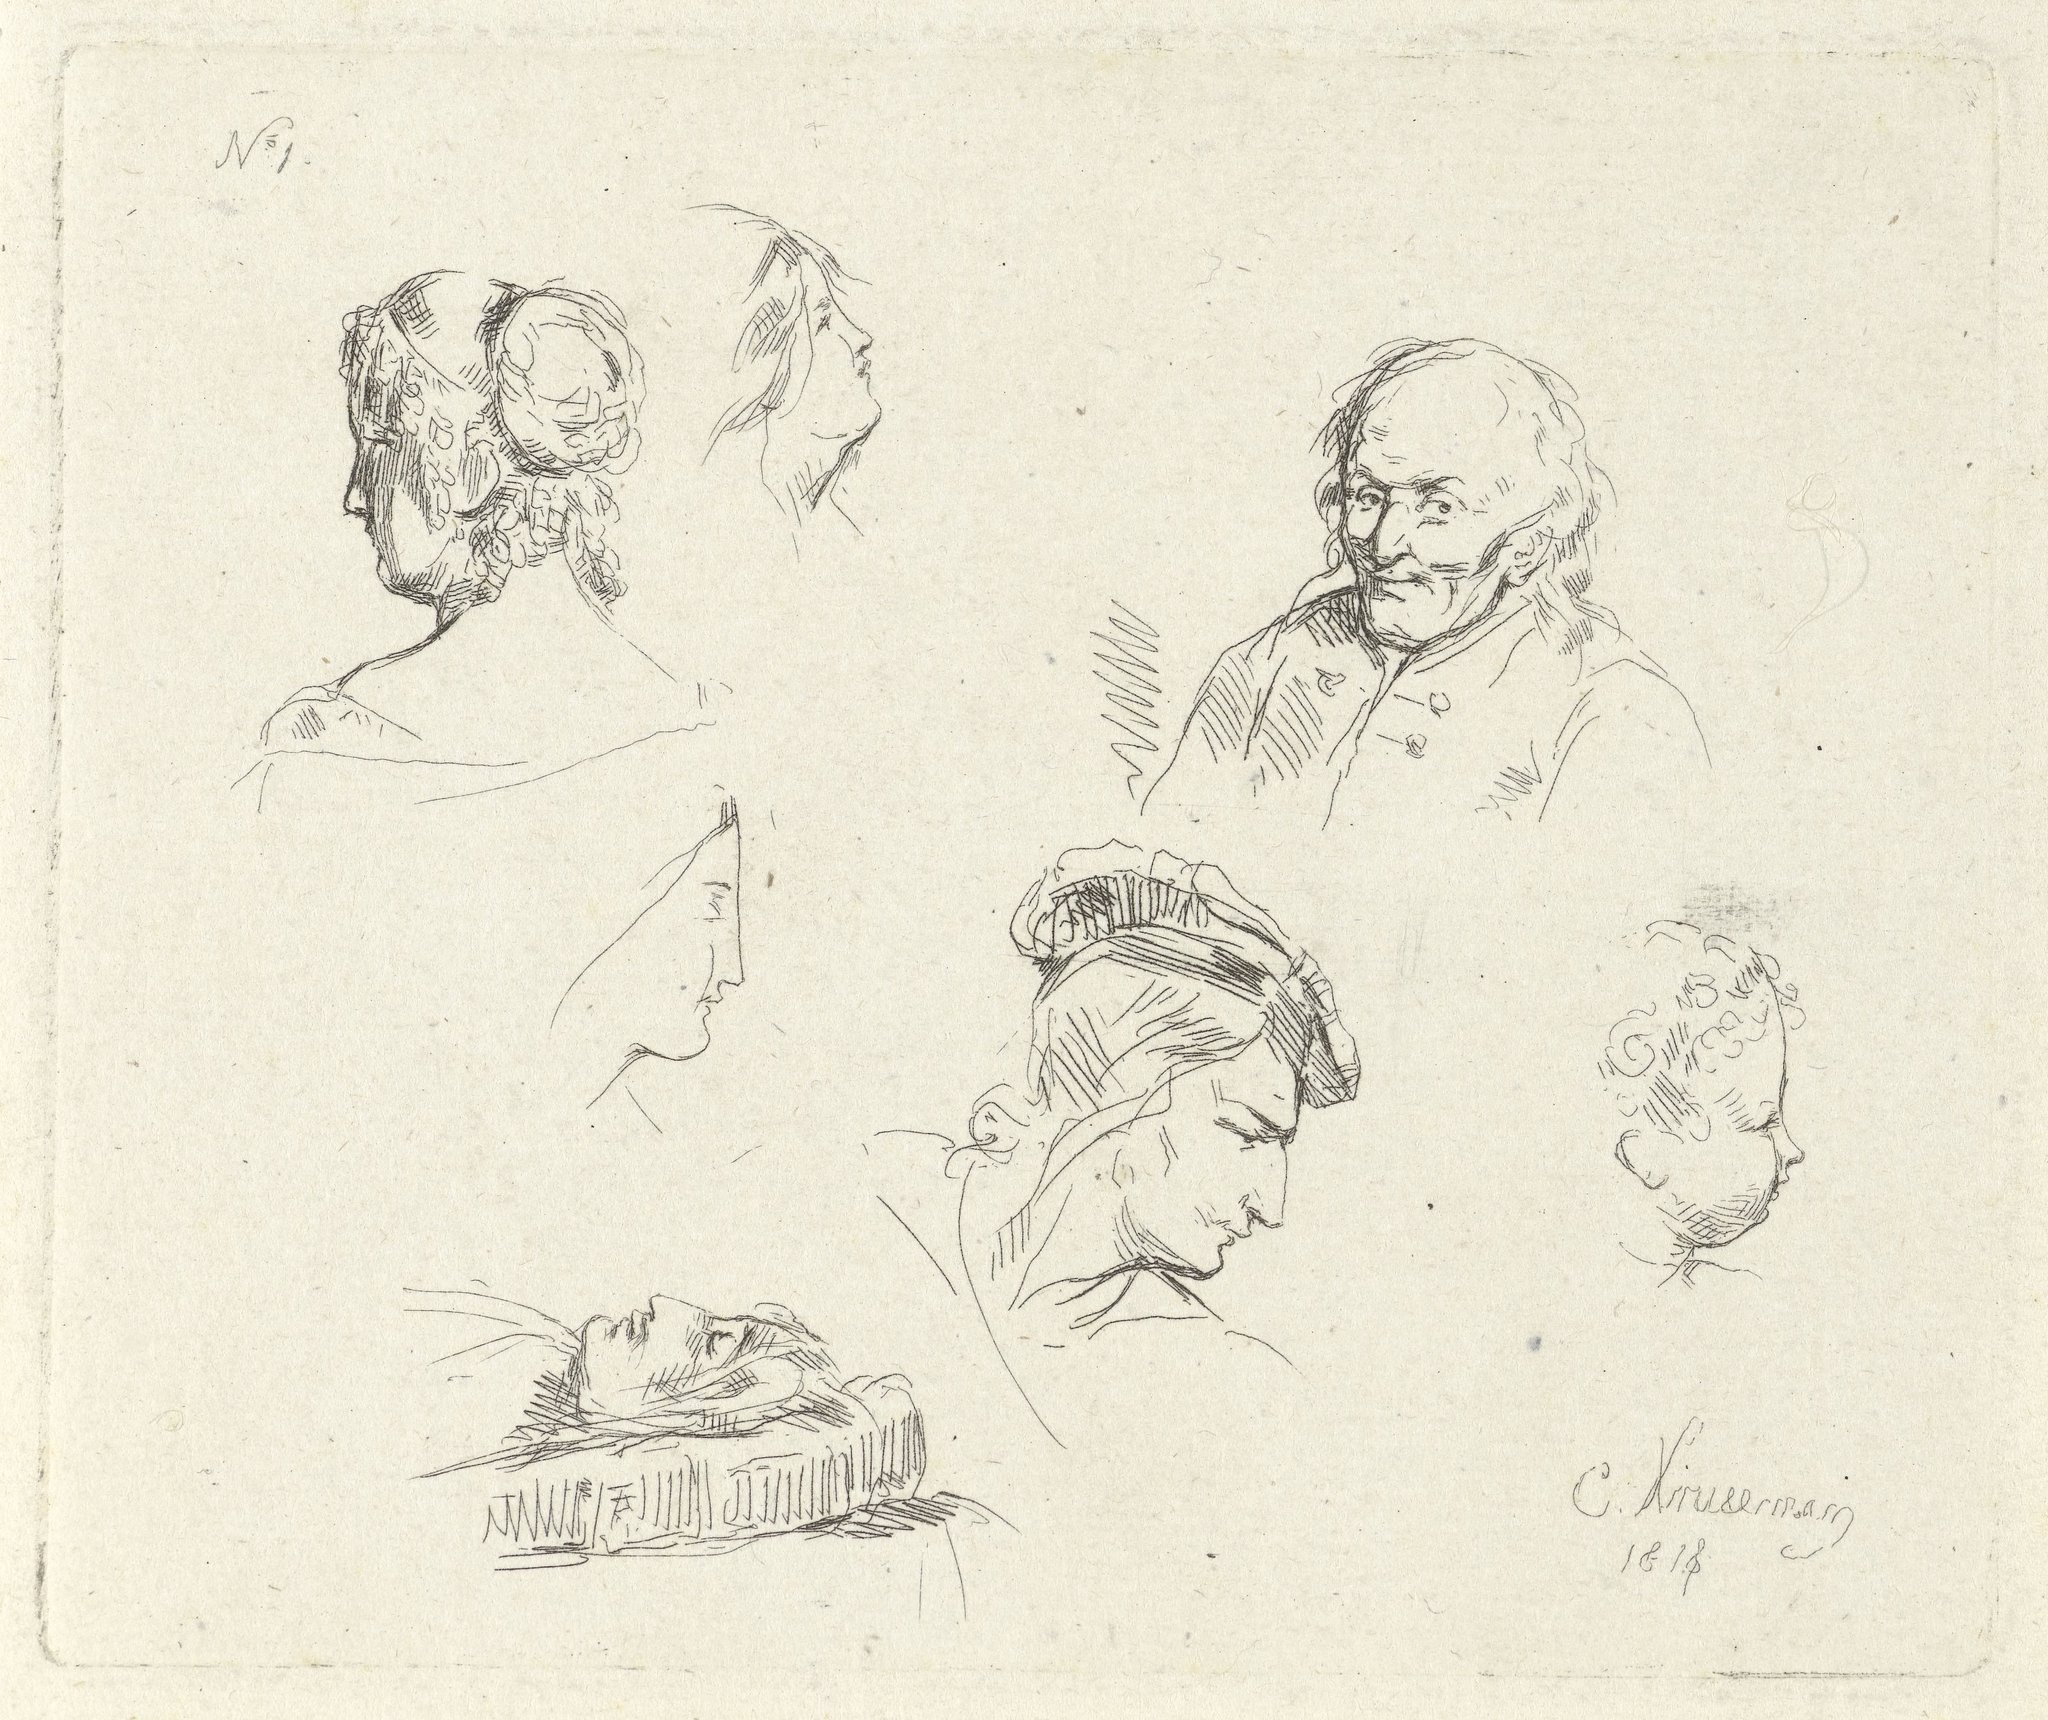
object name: print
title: Studieblad met verschillende koppen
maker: cornelis kruseman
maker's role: draughtsman, painter, print maker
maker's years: 1797-1857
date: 1818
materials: paper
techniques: etching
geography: amsterdam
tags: drawing, sketch, head (human)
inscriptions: collector's mark: Lugt 2228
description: Studieblad met zeven verschillende koppen van mannen en vrouwen.